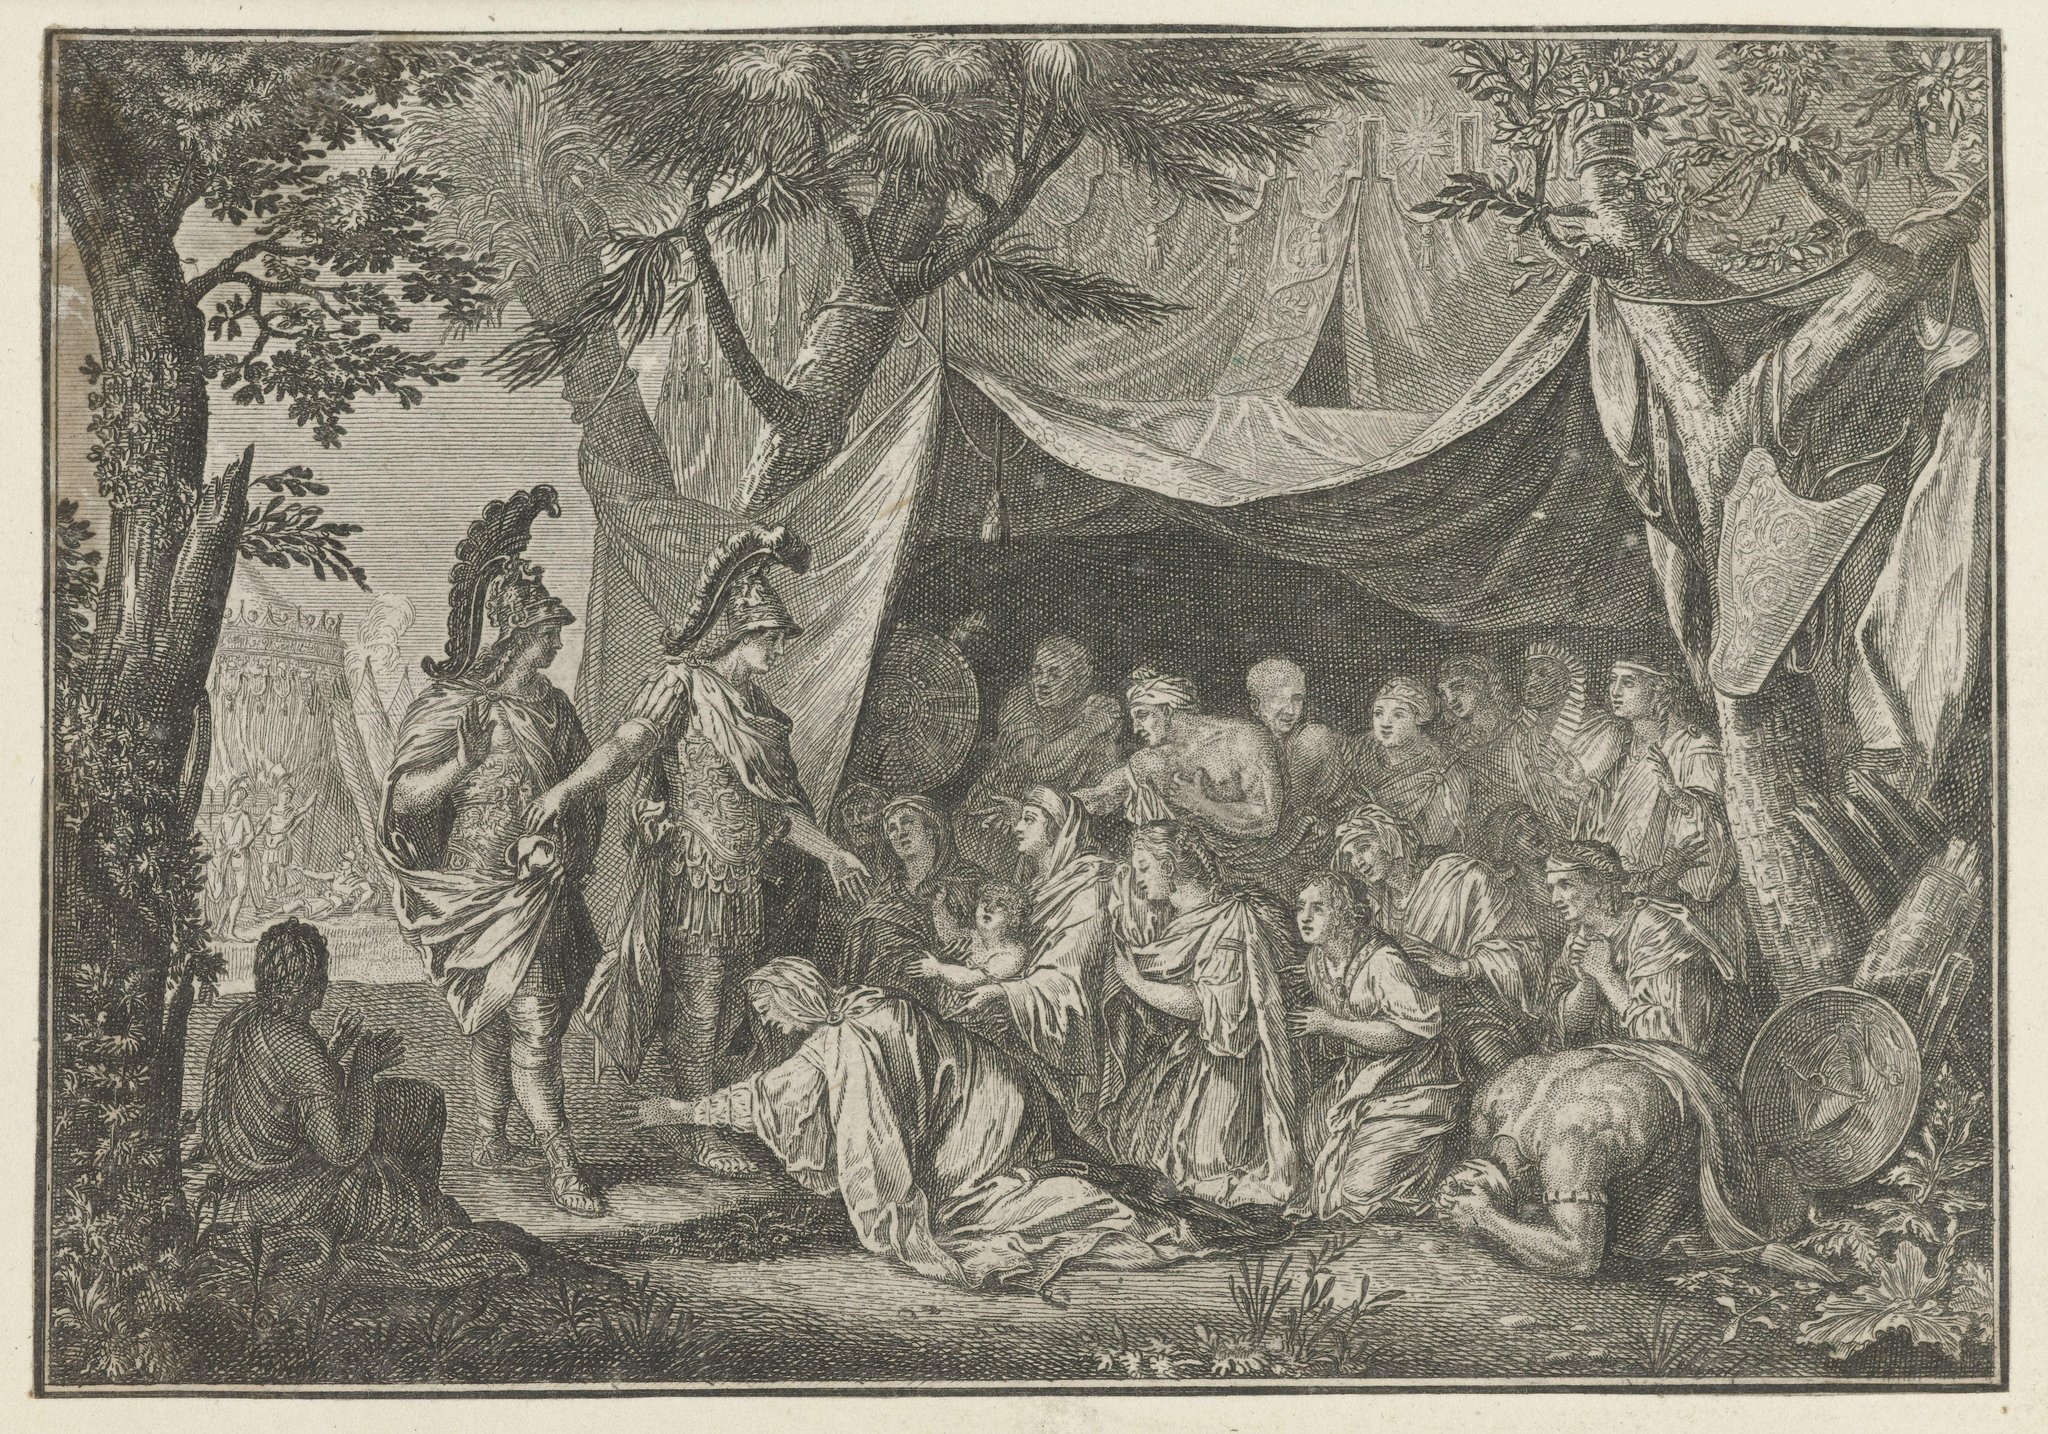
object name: print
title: Werken van Charles le Brun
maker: sébastien leclerc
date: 1647-1714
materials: paper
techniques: engraving, etching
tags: persia, darius' family kneels before alexander, who requests sisigambis, darius' mother, to rise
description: Deze prent maakt deel uit van een album.